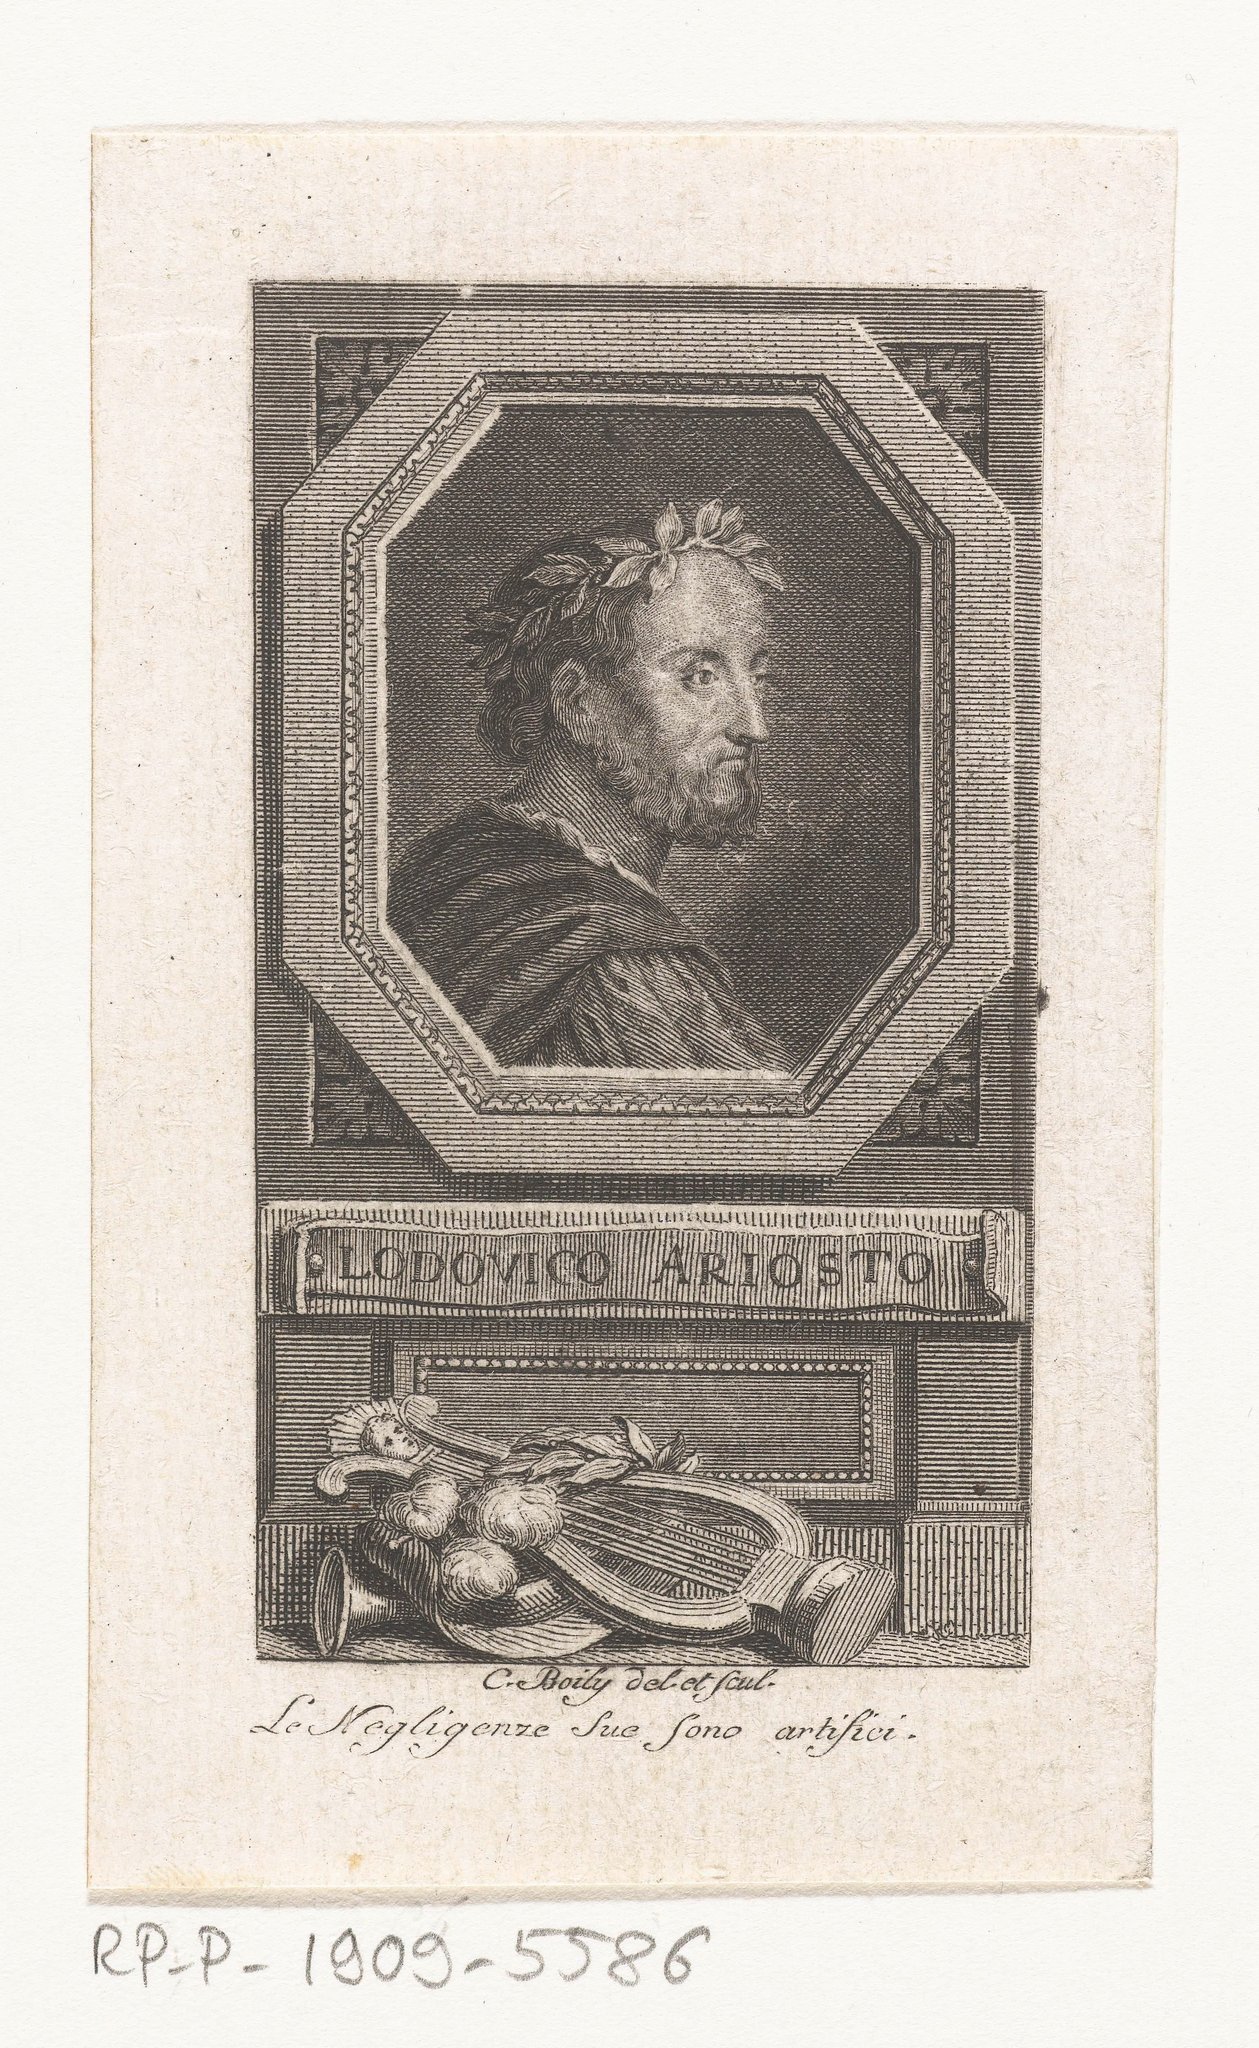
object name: print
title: Lodovico Ariosto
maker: charles ange boily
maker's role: print maker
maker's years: 1738-1813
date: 1753-1813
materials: paper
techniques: etching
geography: netherlands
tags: ludovico ariosto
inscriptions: collector's mark: Lugt 2228